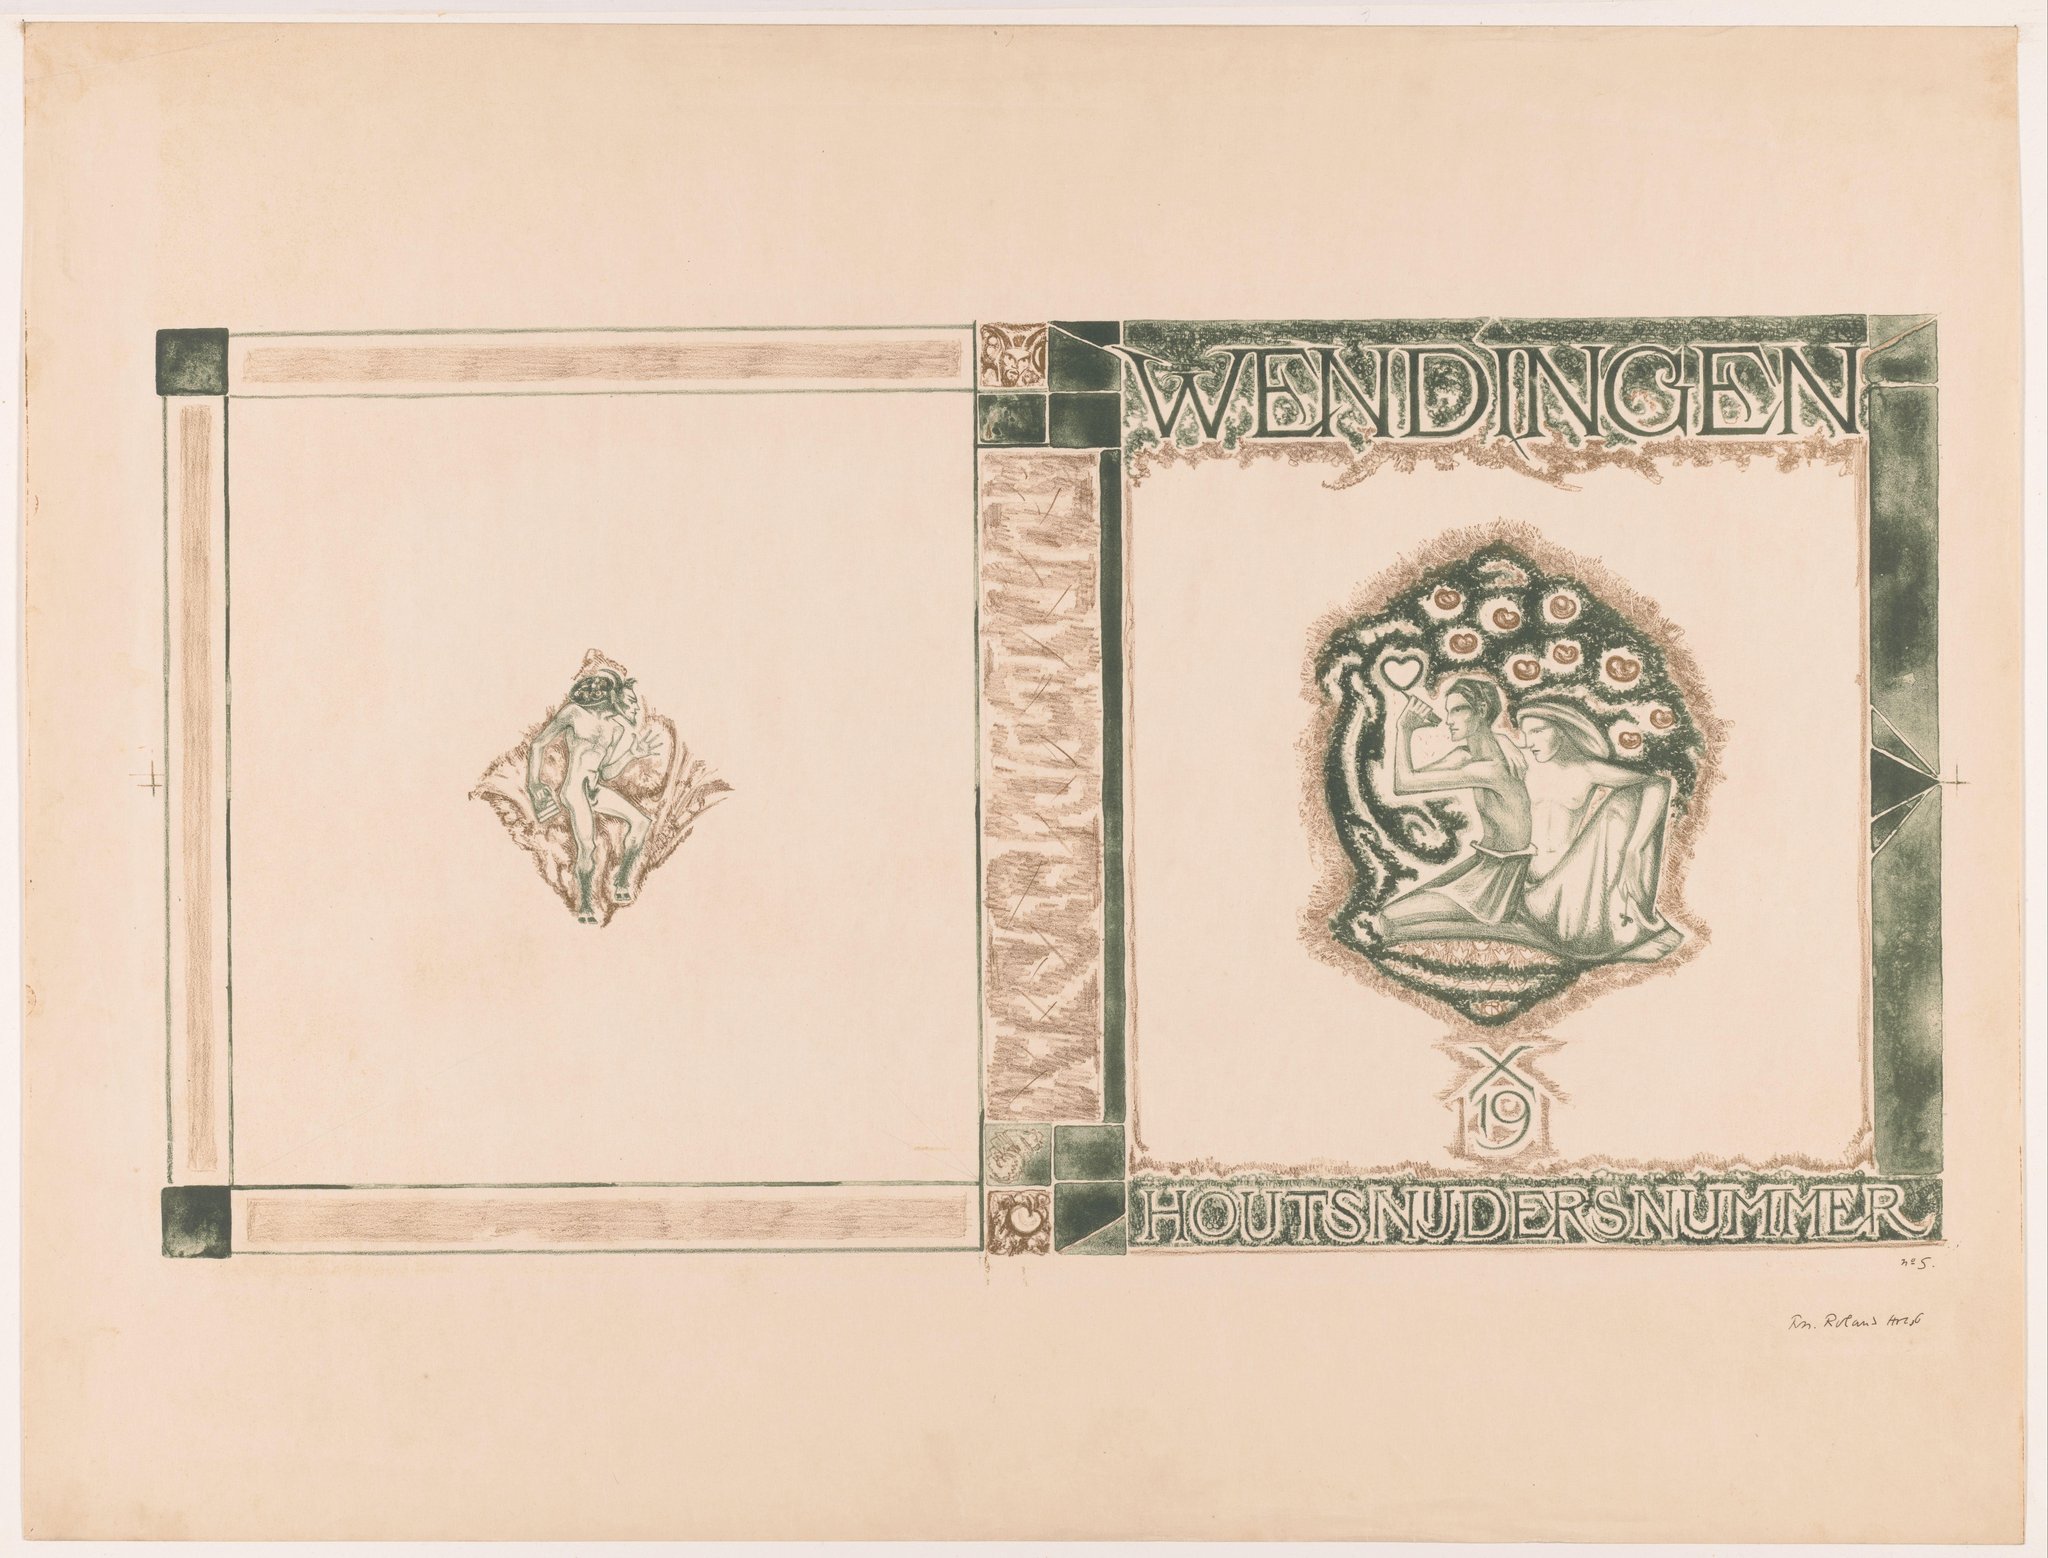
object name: print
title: Omslagontwerp voor: Wendingen, Houtsnijdersnummer, 1919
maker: richard nicolaüs roland holst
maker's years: 1868-1938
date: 1919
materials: paper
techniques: lithograph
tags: fruit-tree culture; fruit harvest, satyr(s) (in general), wood carver, carving heart and initials in an object, e.g. a tree trunk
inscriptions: number: ‘5’, collector's mark: Lugt 2228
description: Links een sater in een bos. Rechts een halfnaakte man en een vrouw, zittend bij een fruitboom. De man kerft een hart in de stam van de boom. De vrouw houdt een klaver vast in haar hand.